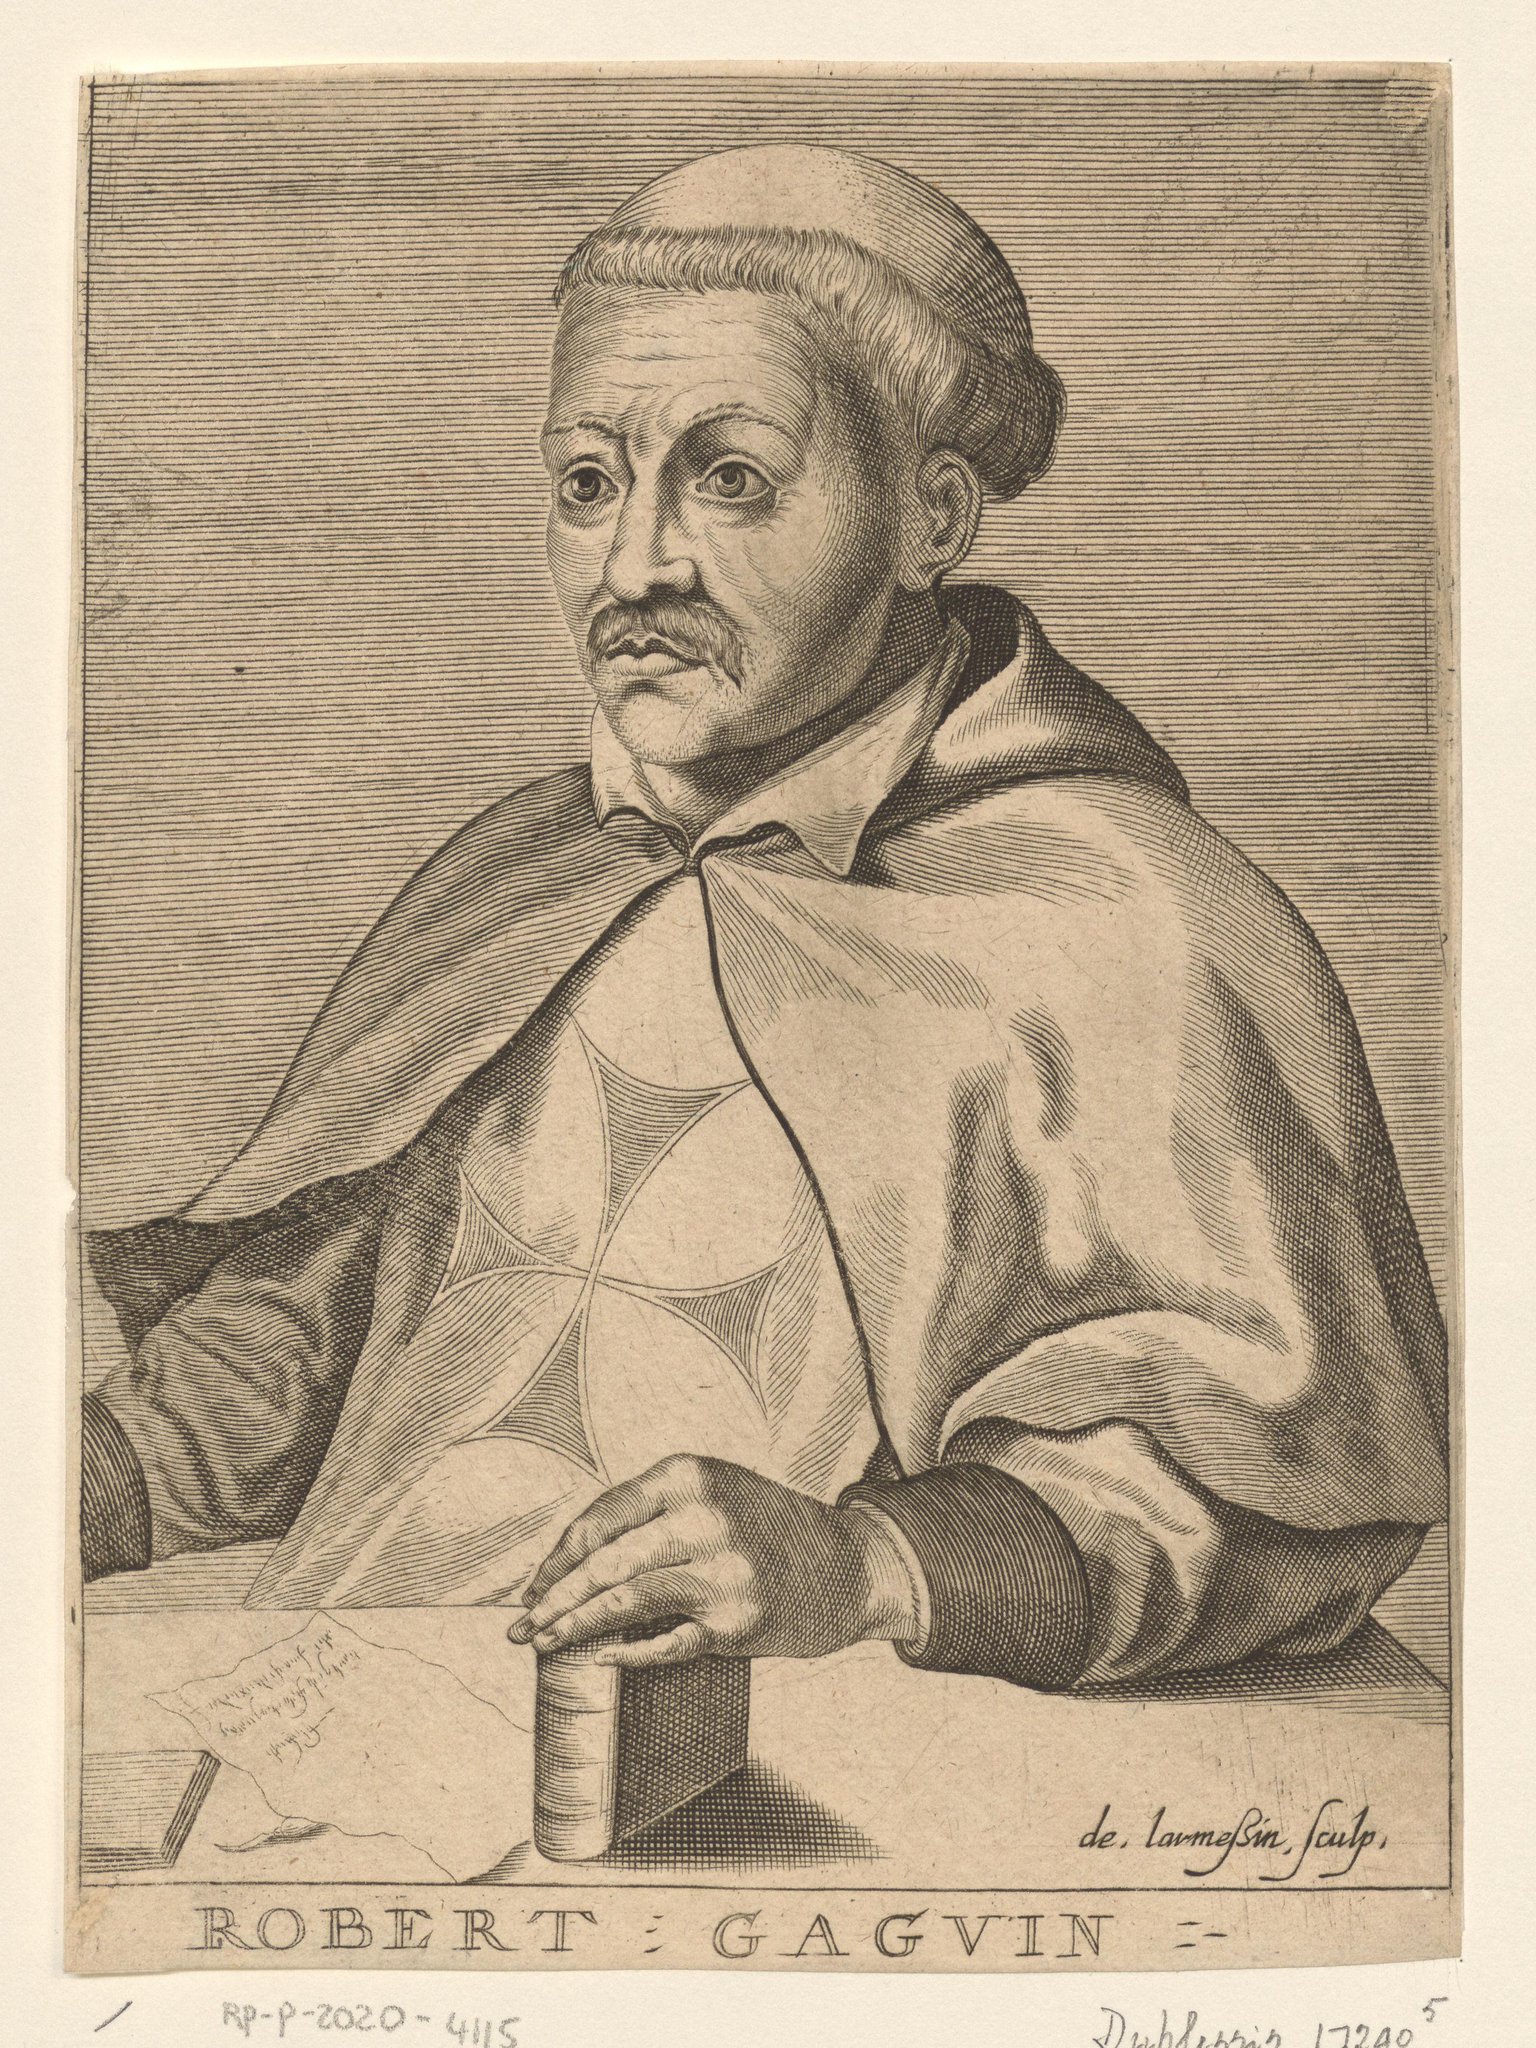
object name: print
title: Portret van Robert Gaguin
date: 1682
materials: paper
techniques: engraving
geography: brussels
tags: paris, scholar, philosopher, historical persons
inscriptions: collector's mark: Lugt 2228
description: Andere staat van de prent gebruikt in: Bullart, Isaac. Académie des Sciences et Arts contenant les vies et éloges his. des hommes illustres qui ont excellé en ces professions depuis environ quatre siècles. Brussel: François Foppens, 1682. Het boek werd in 1682 eveneens in Amsterdam uitgegeven door de erfgenamen van Daniel Elzevier. Ieder portret betreft een illustratie bij de biografie van een kunstenaar of geleerde. De meeste portretten (162 stuks) werden door Nicolas de Larmessin vervaardigd, 93 prenten werden door De Boulonois gemaakt en de rest door ongeïdentificeerde prentmakers. Deze prent heeft echter geen boekdruk op verso en is mogelijk een proefdruk of in een andere uitgave gebruikt.